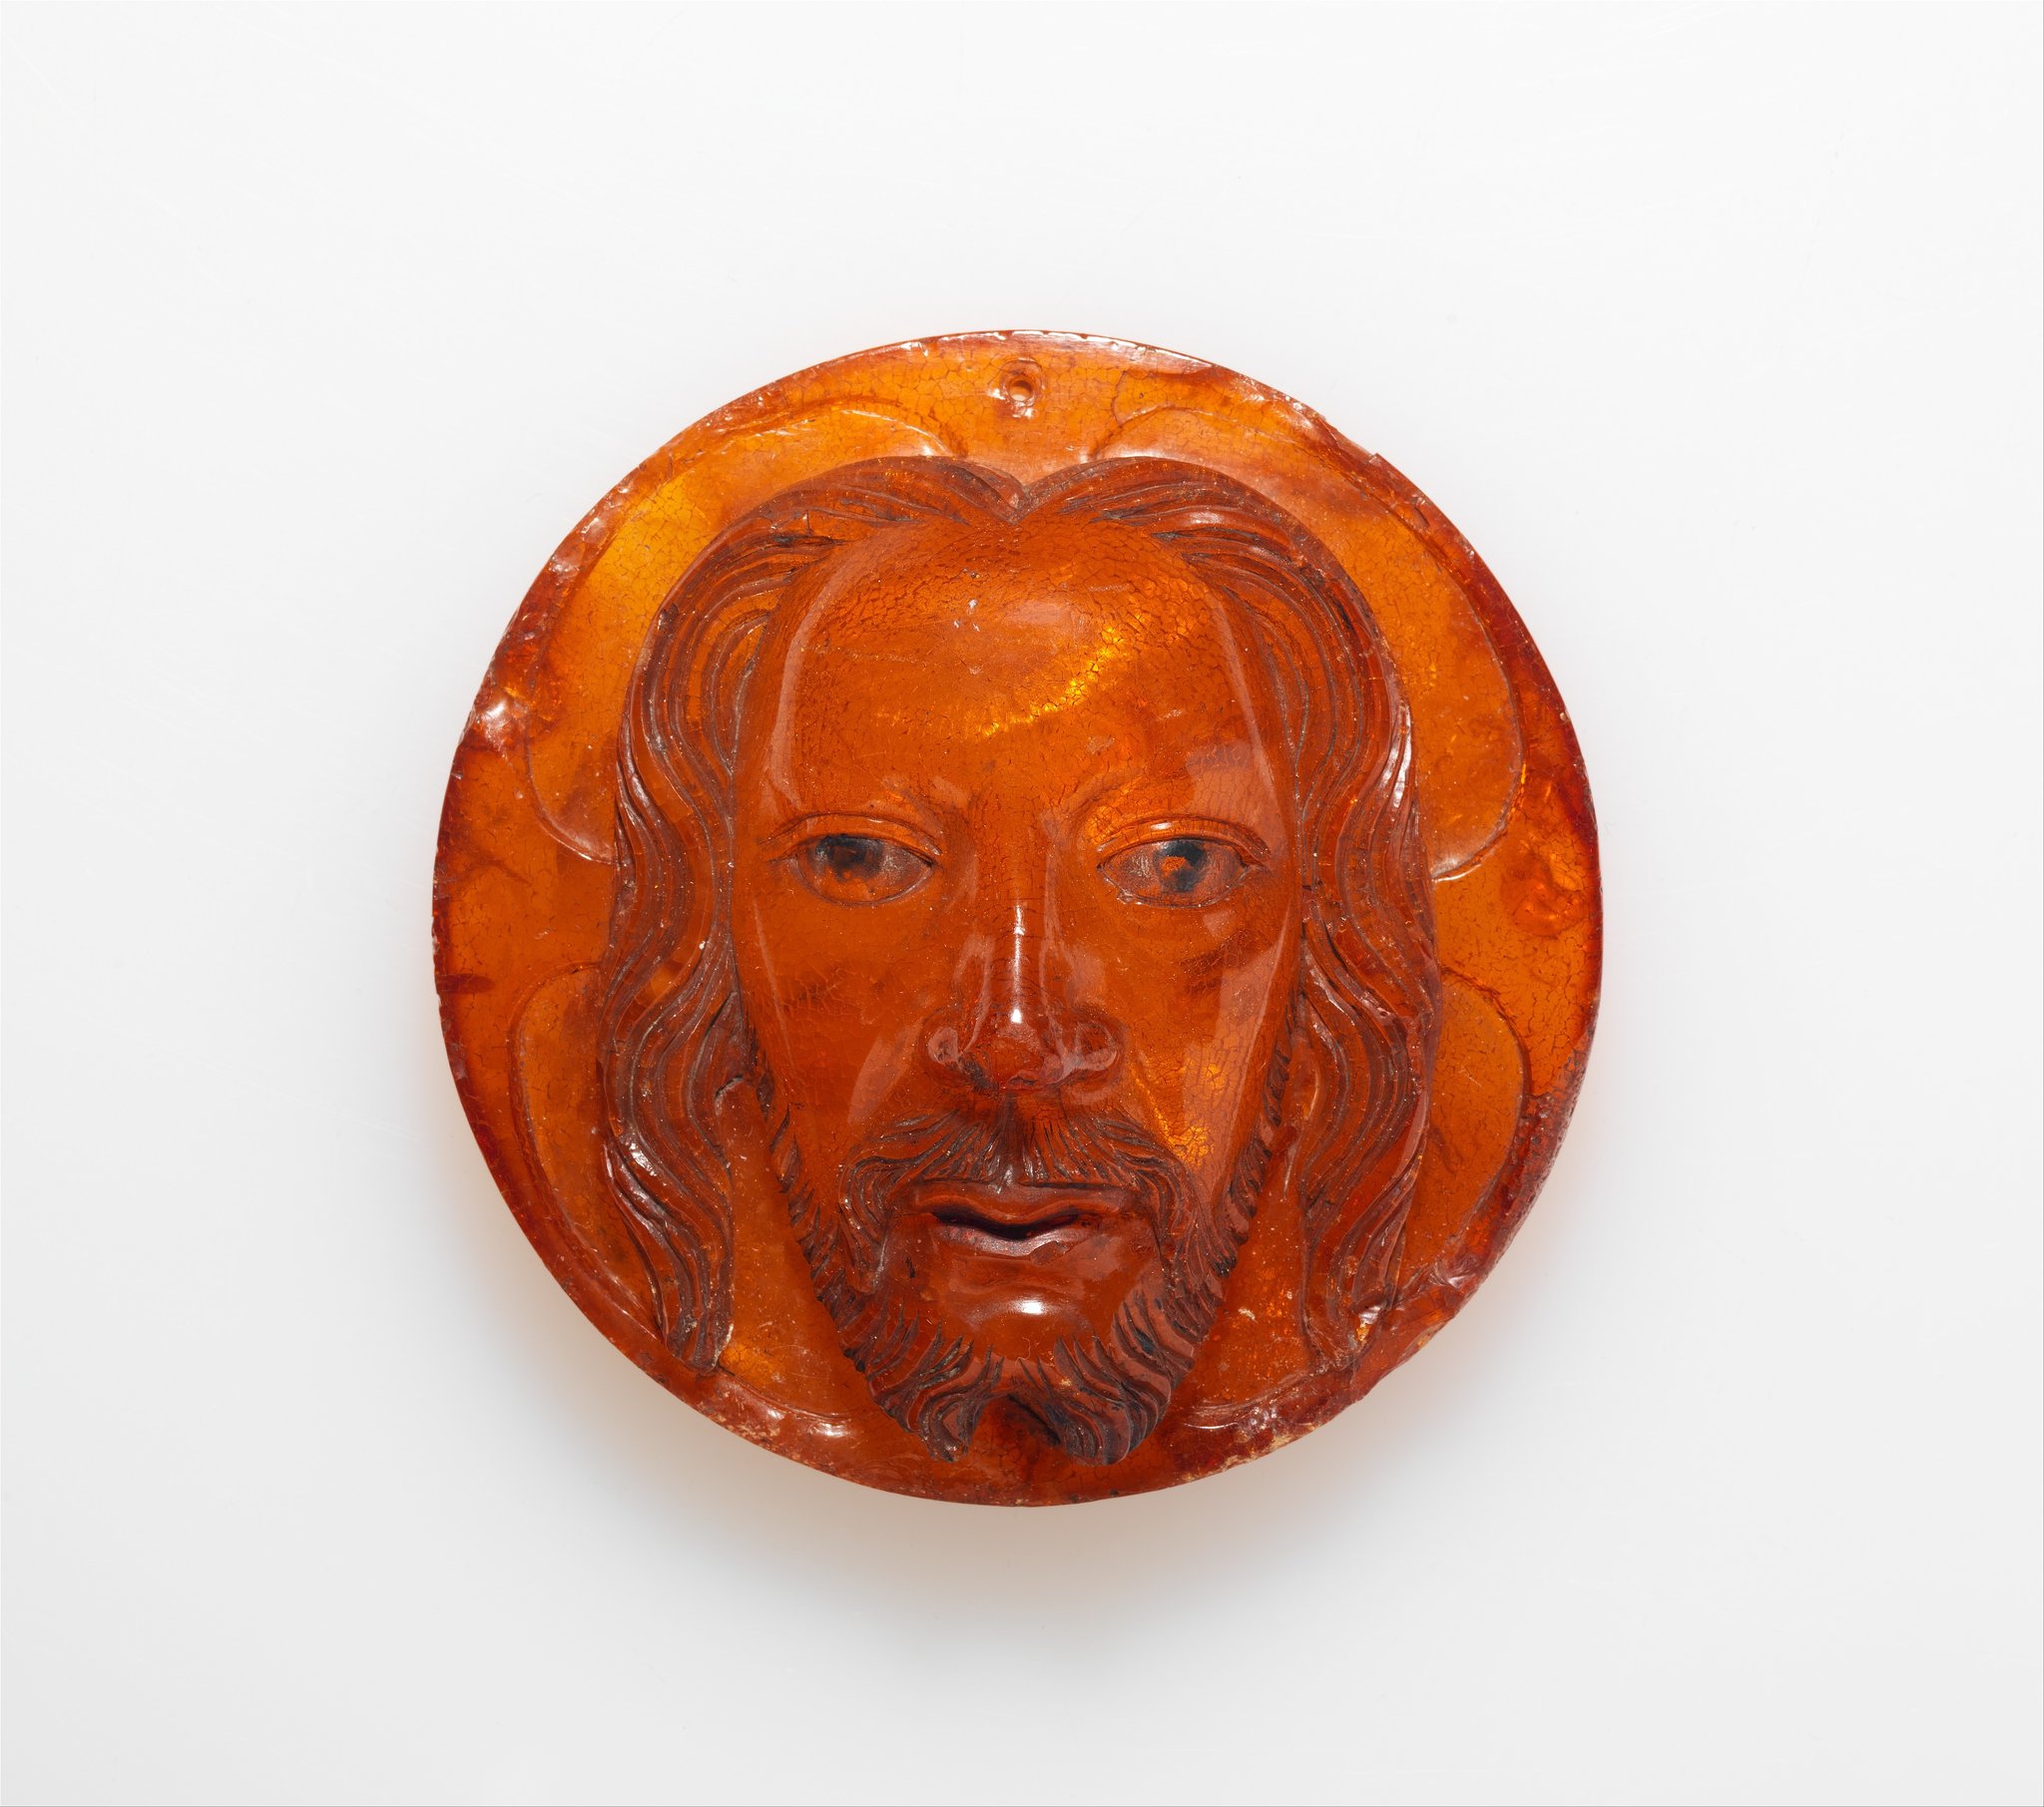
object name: medallion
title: Medallion with the Face of Christ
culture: polish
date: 1380-1400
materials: amber, paint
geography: poland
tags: christ